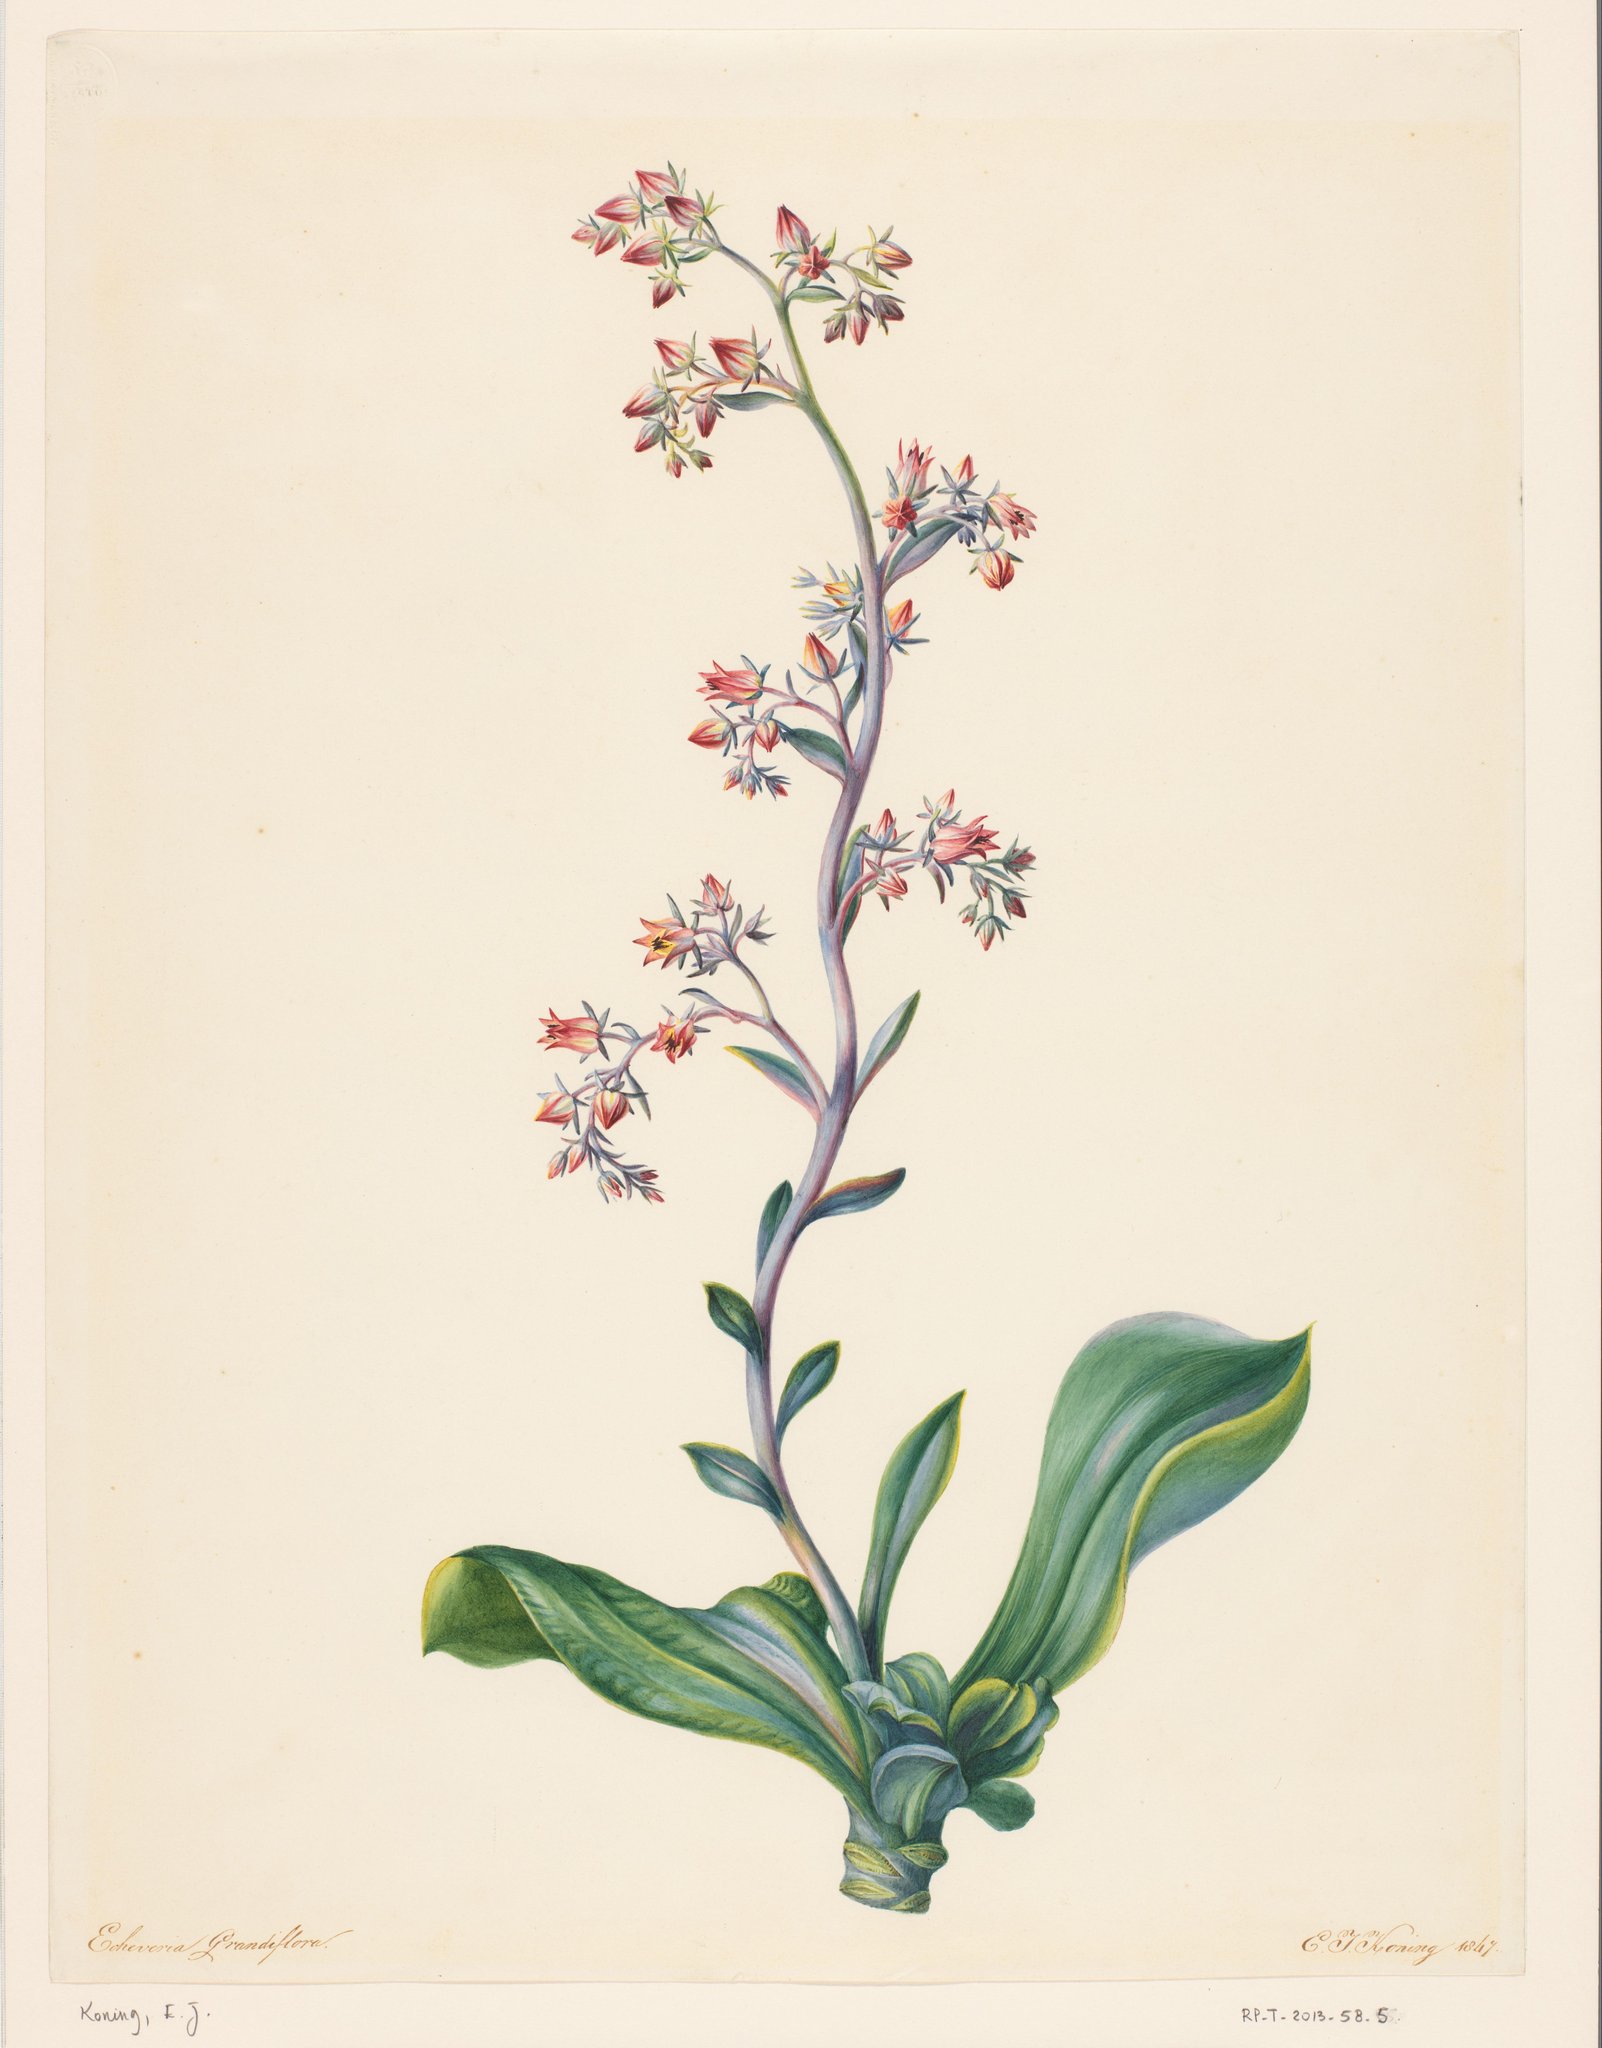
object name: drawing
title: Echeveria Grandiflora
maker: elisabeth johanna koning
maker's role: print maker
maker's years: 1816-1887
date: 1847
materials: paper, pencil, watercolor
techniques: brush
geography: netherlands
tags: plants and herbs: echeveria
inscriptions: date